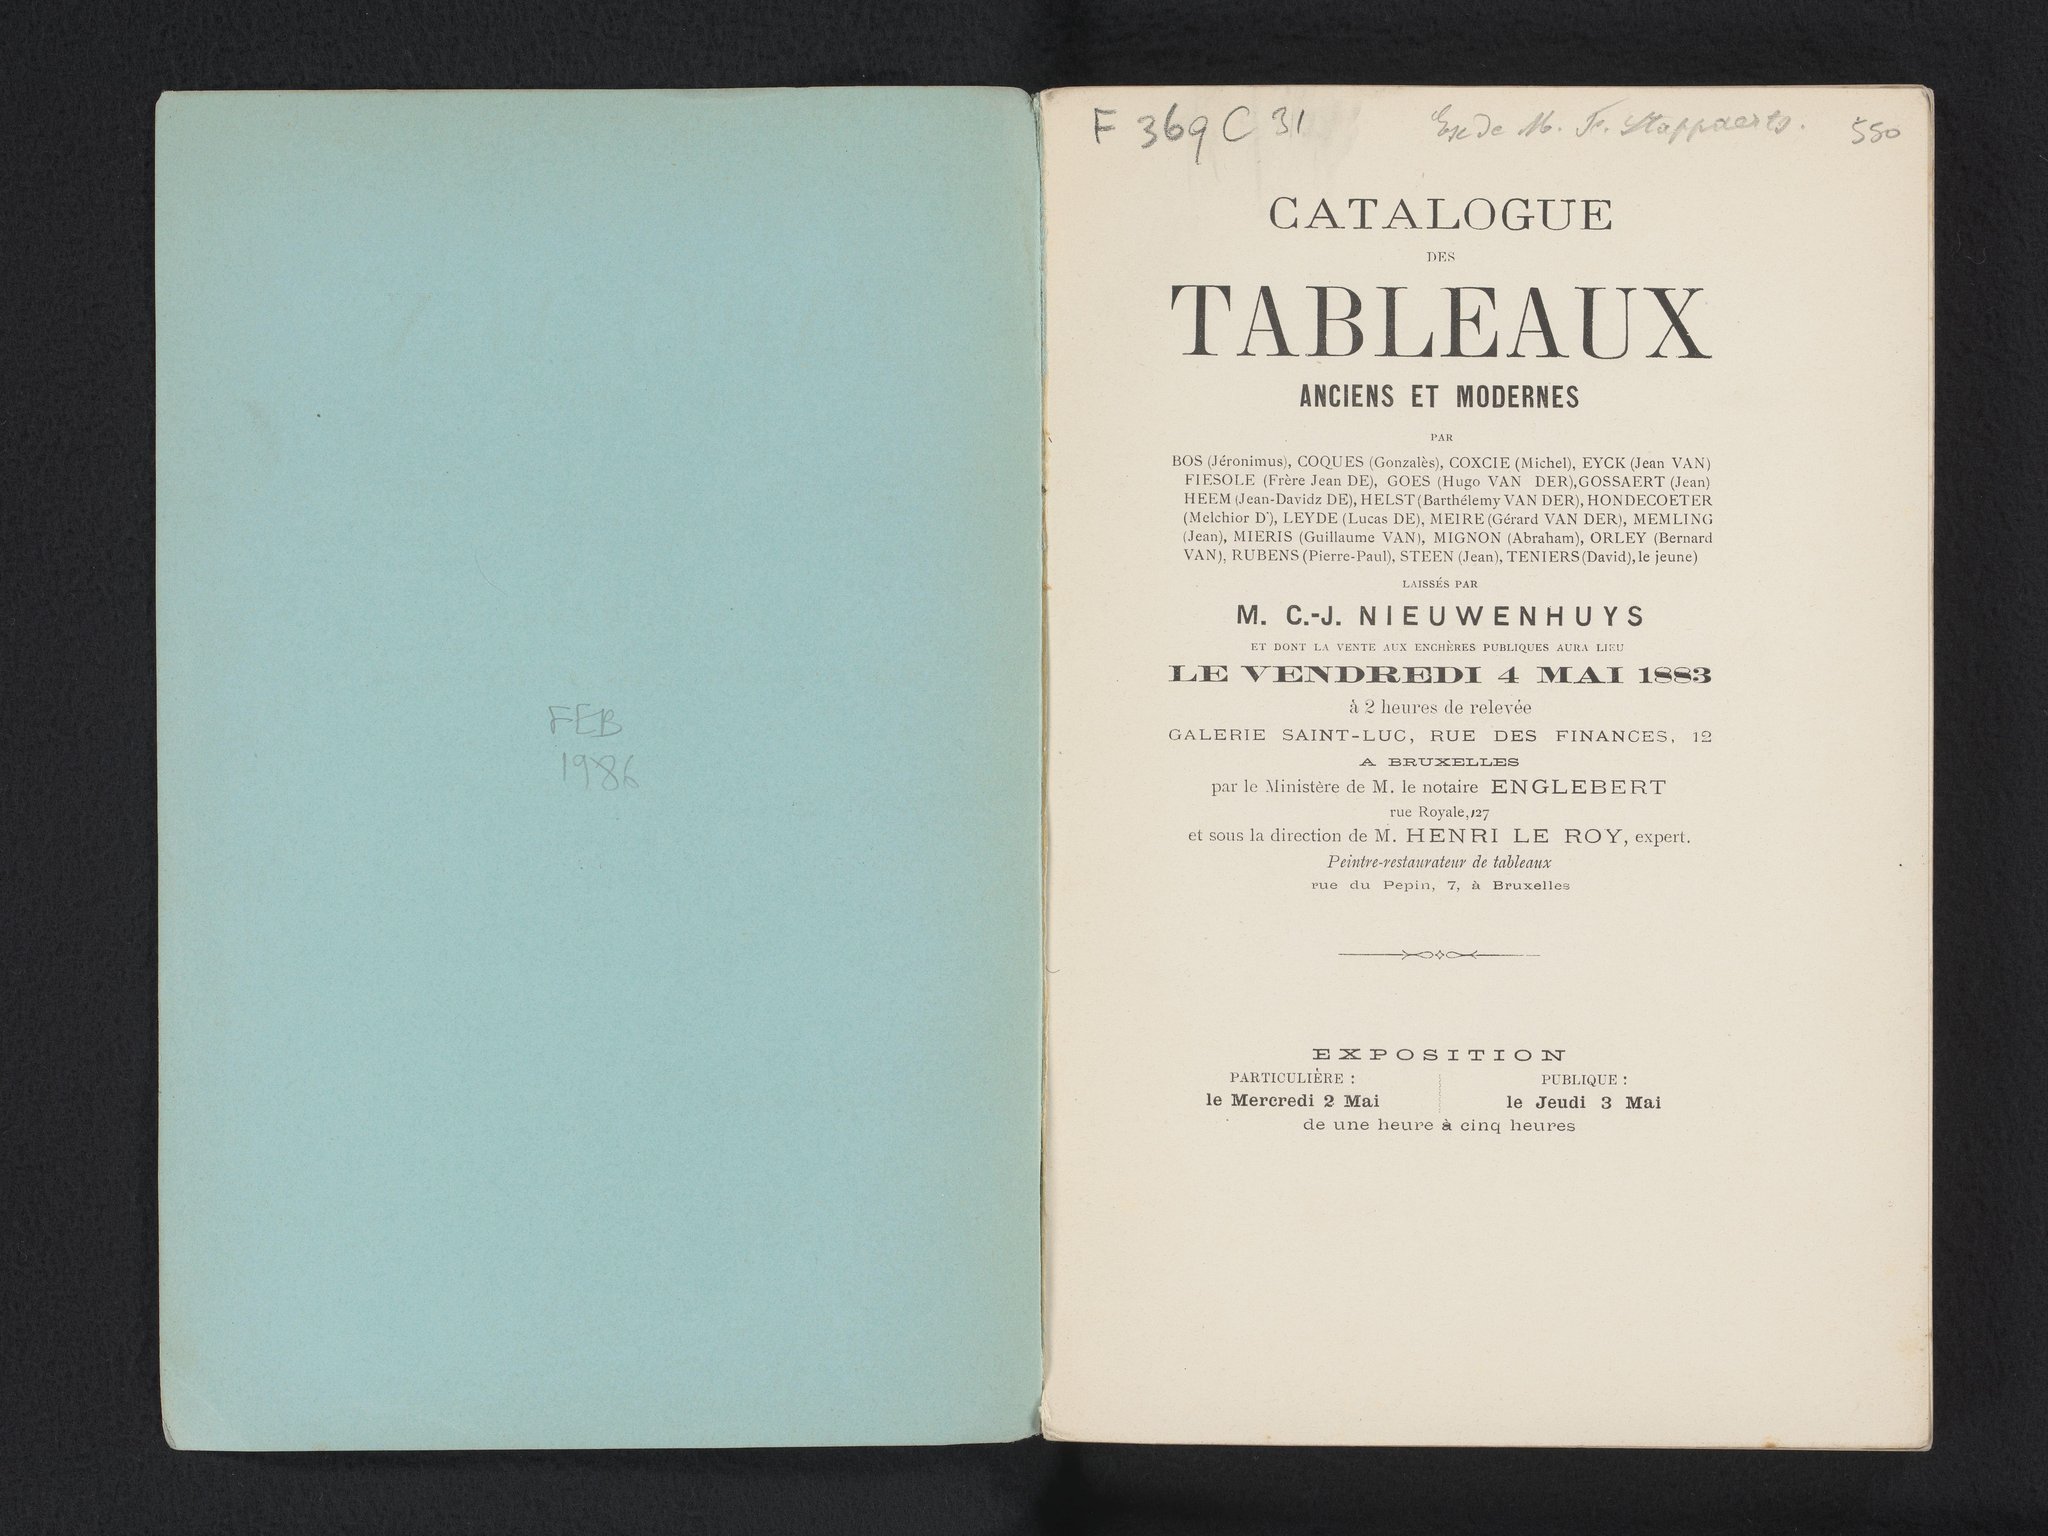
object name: book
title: Catalogue des tableaux anciens et modernes par Bos (Jéronimus) ... Teniers (David), le jeune) laissés par M. C.-J. Nieuwenhuys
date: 1883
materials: linen, paper, photographic support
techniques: albumen print, printing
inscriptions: annotation: ‘Photo’, annotation: ‘[...] De M. F. Mappaerts 550’, date: ‘FEB 1986’